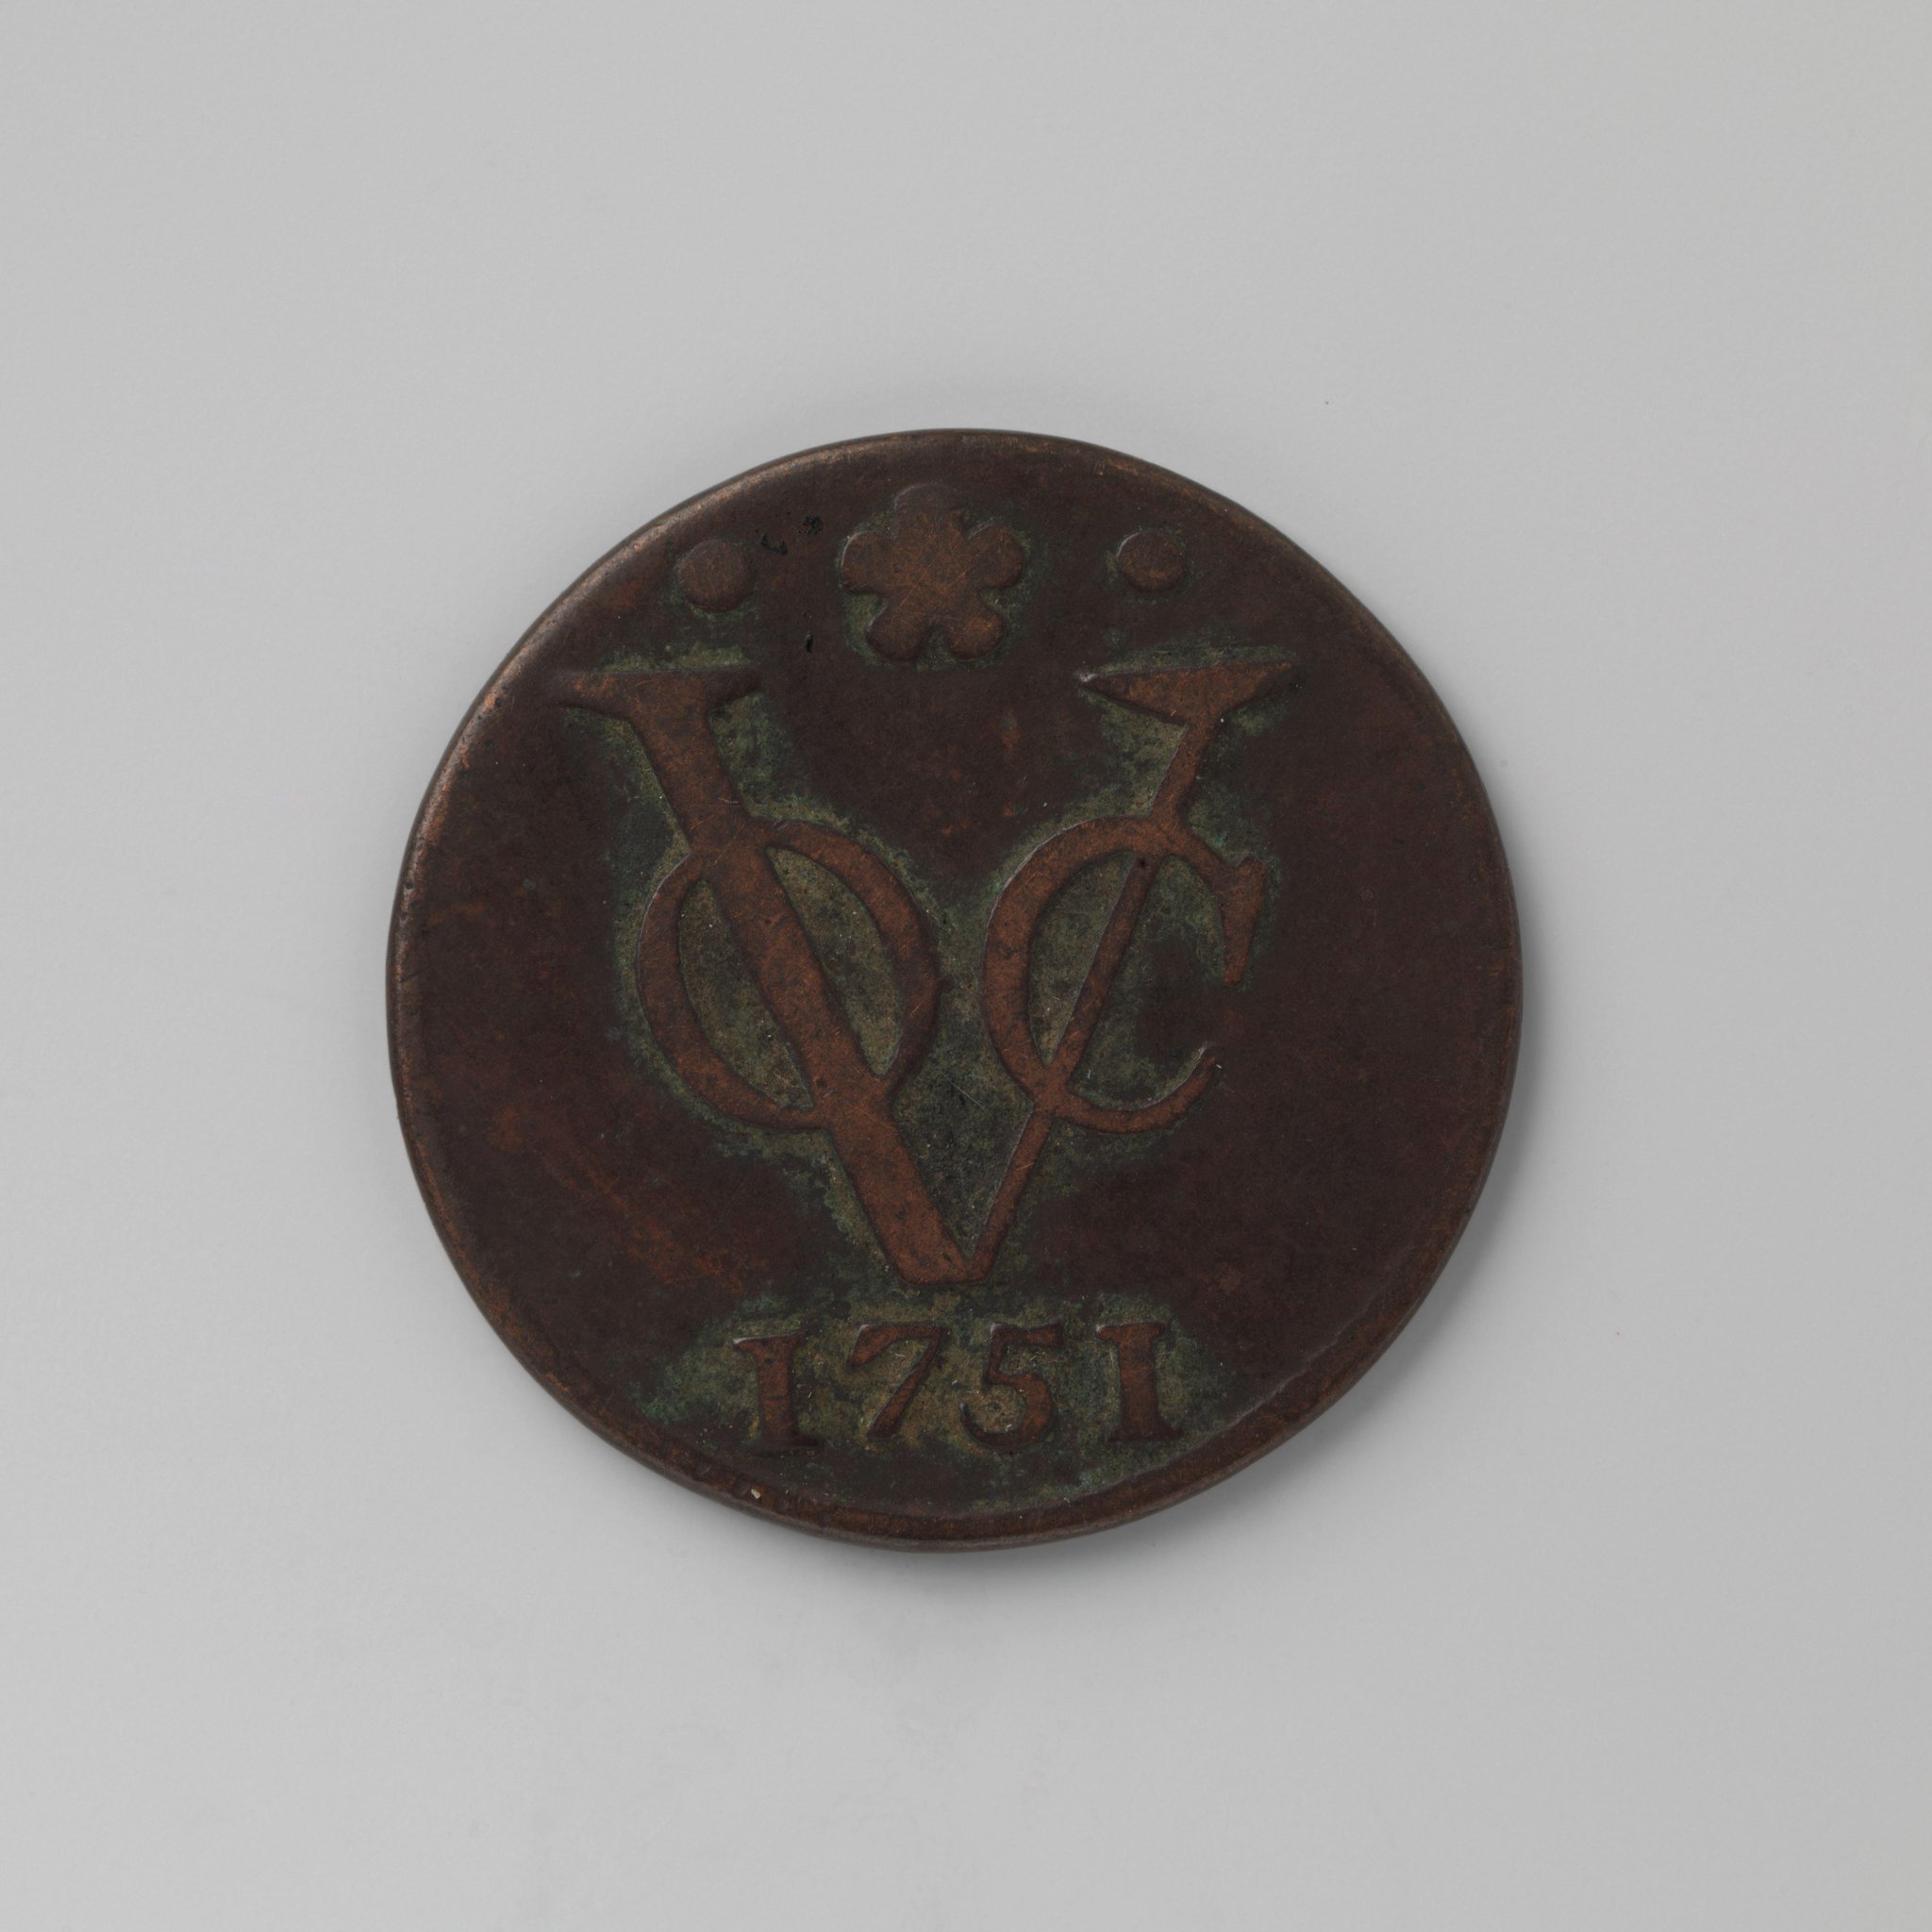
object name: coin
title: VOC, duit Holland, 1751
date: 1751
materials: copper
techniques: striking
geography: dordrecht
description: Koperen munt. Voorzijde: gekroond wapenschild van Holland. Keerzijde: monogram van de VOC, waarboven muntteken en waaronder jaartal. Gladde rand.